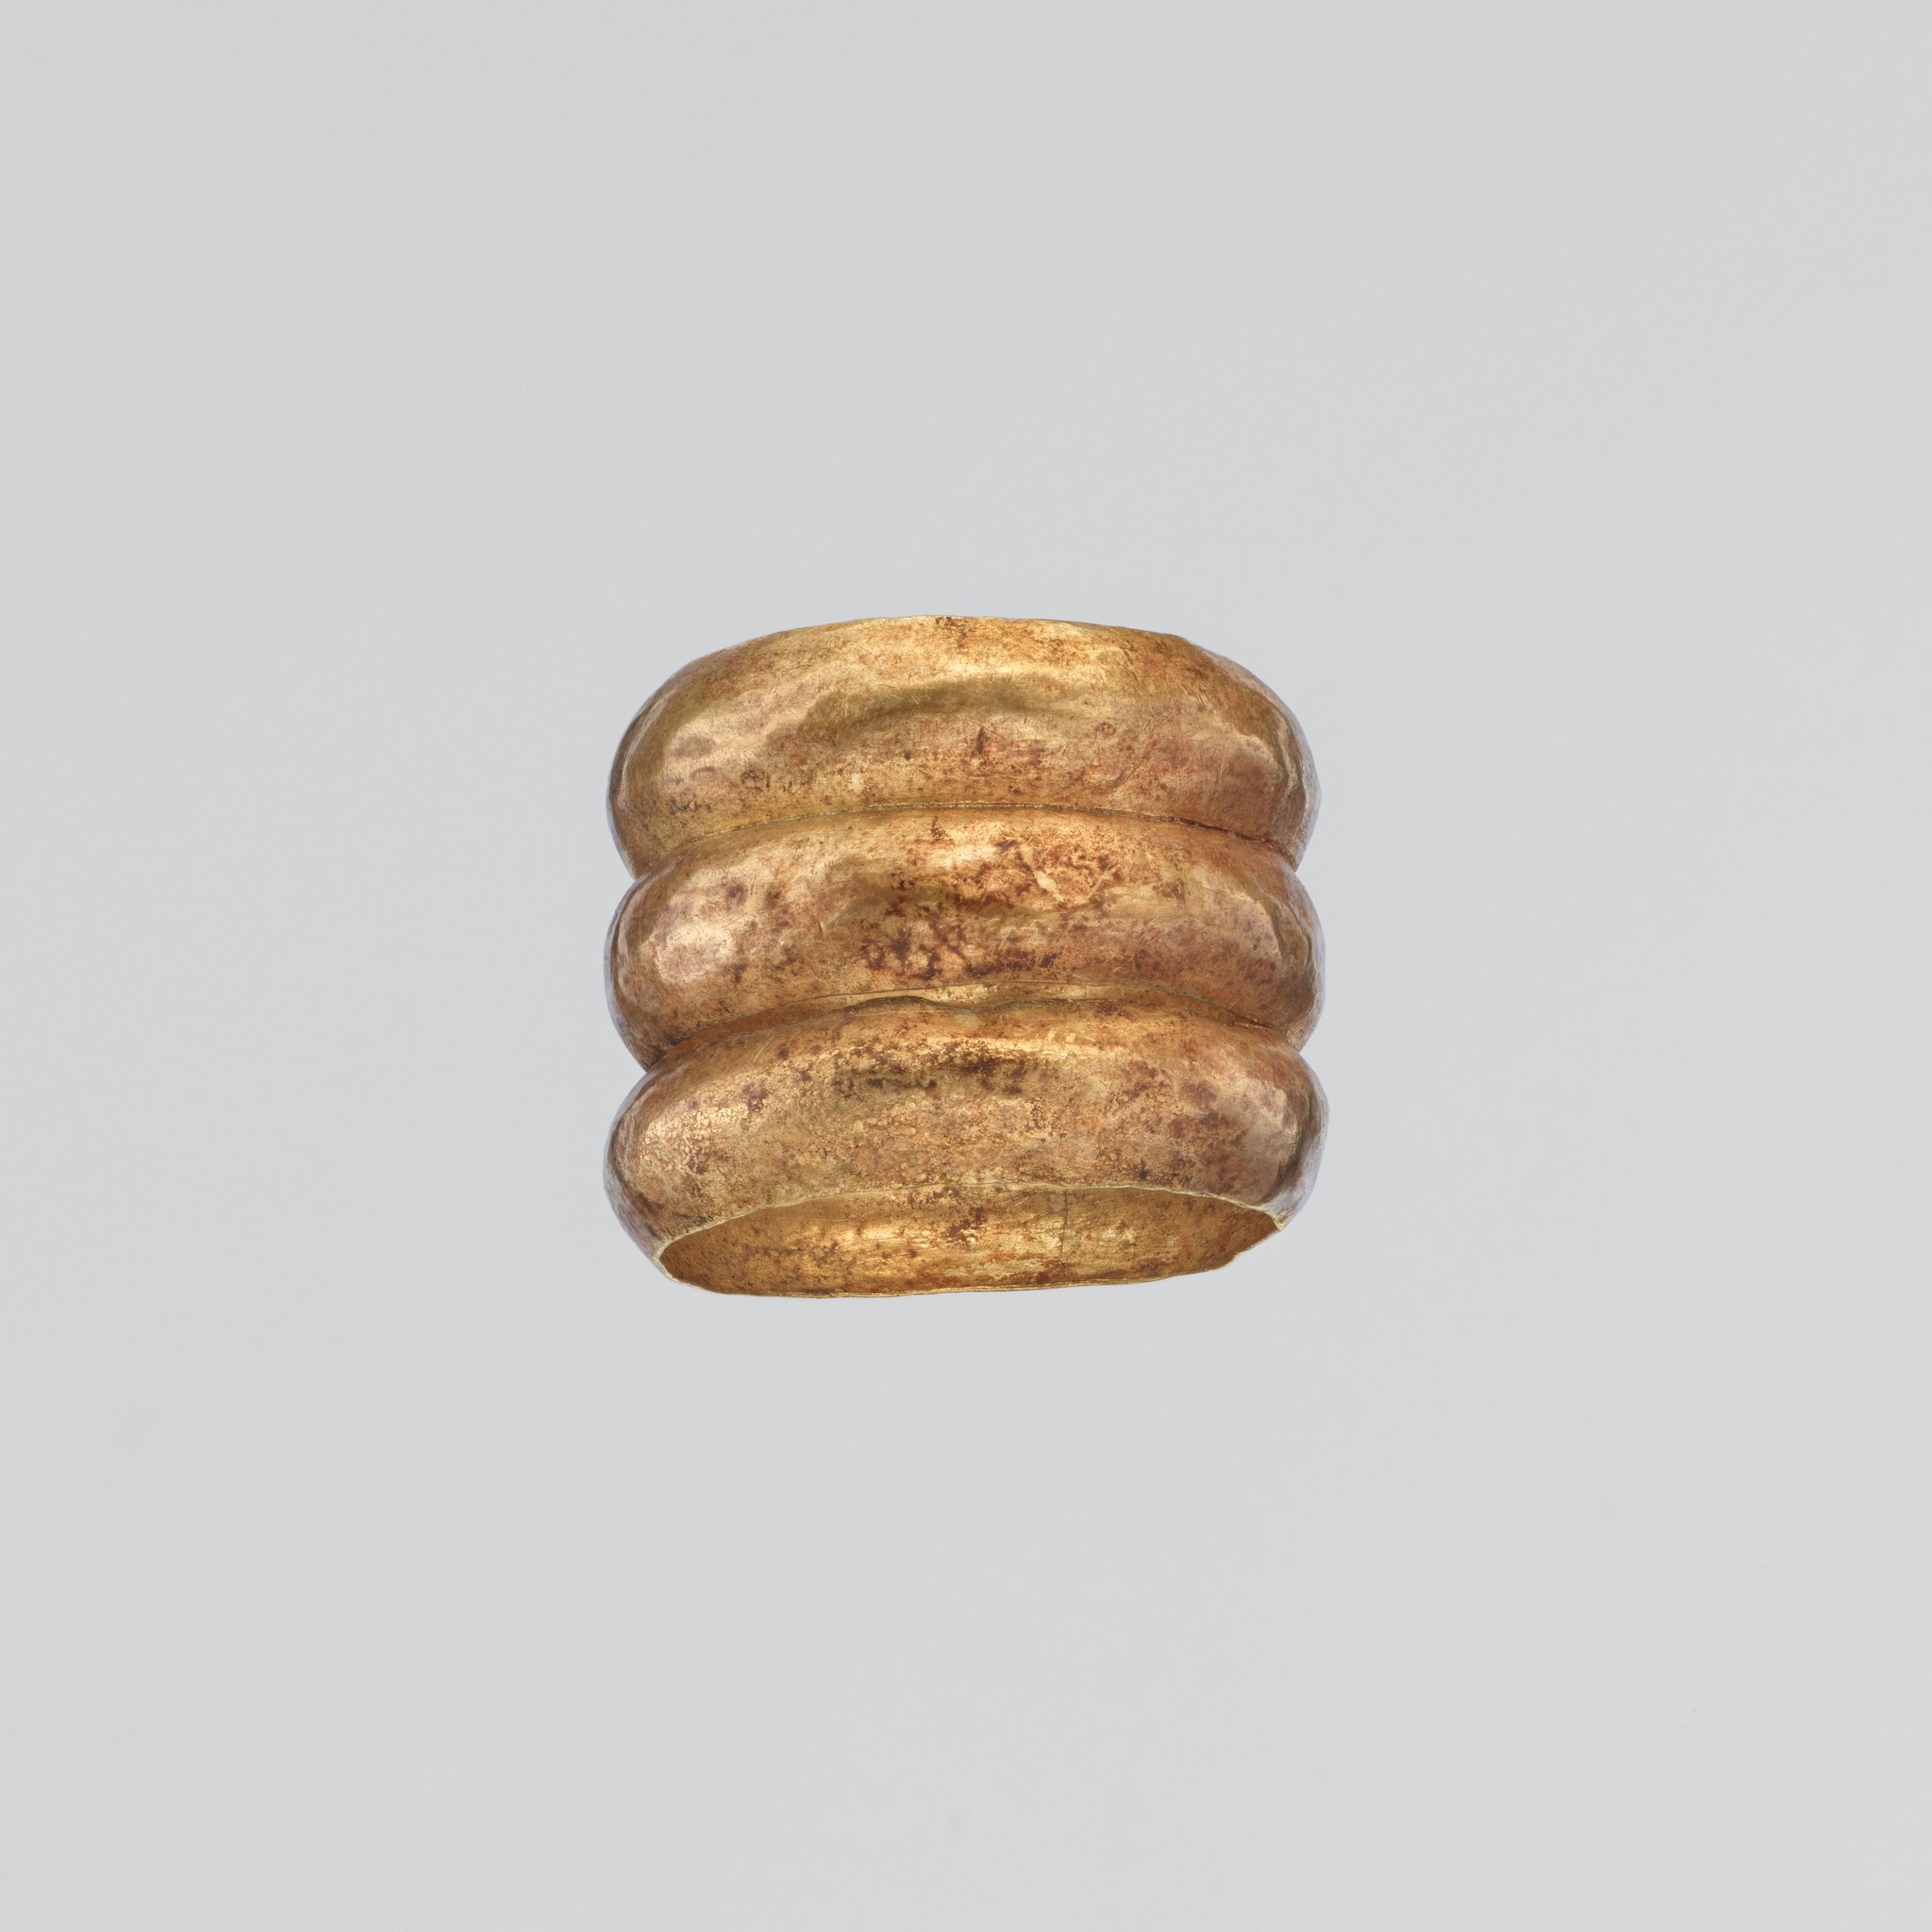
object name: ring, three joined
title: Multiple gold ring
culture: cypriot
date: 1050-850 BCE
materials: gold